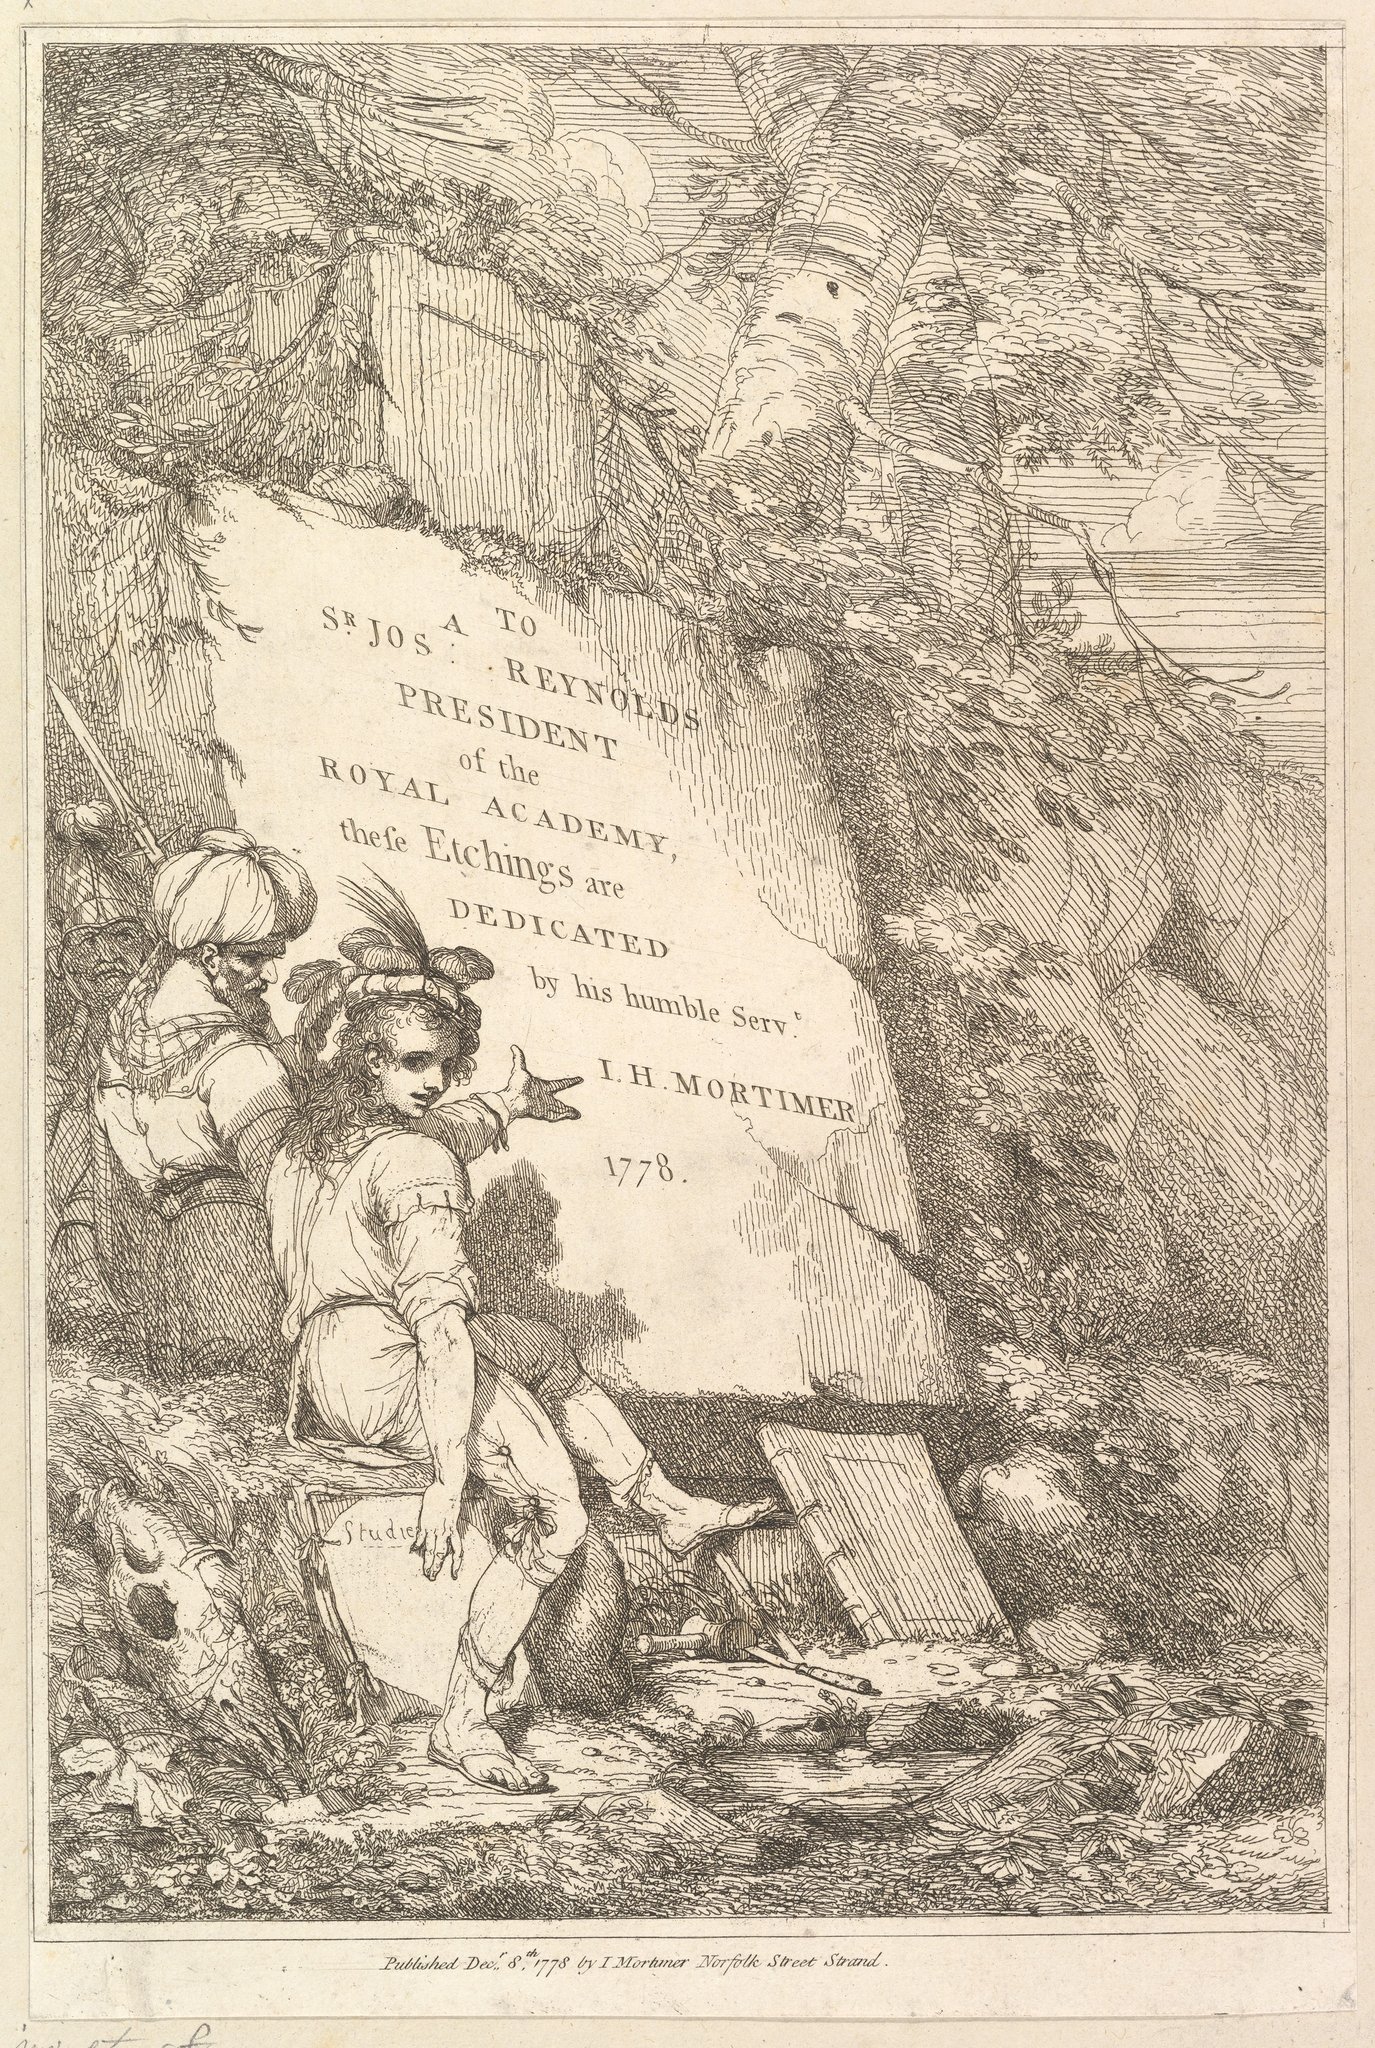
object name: print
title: Frontispiece, from "Fifteen Etchings Dedicated to Sir Joshua Reynolds"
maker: john hamilton mortimer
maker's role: artist and publisher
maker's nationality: british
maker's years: 1740-1779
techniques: etching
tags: men